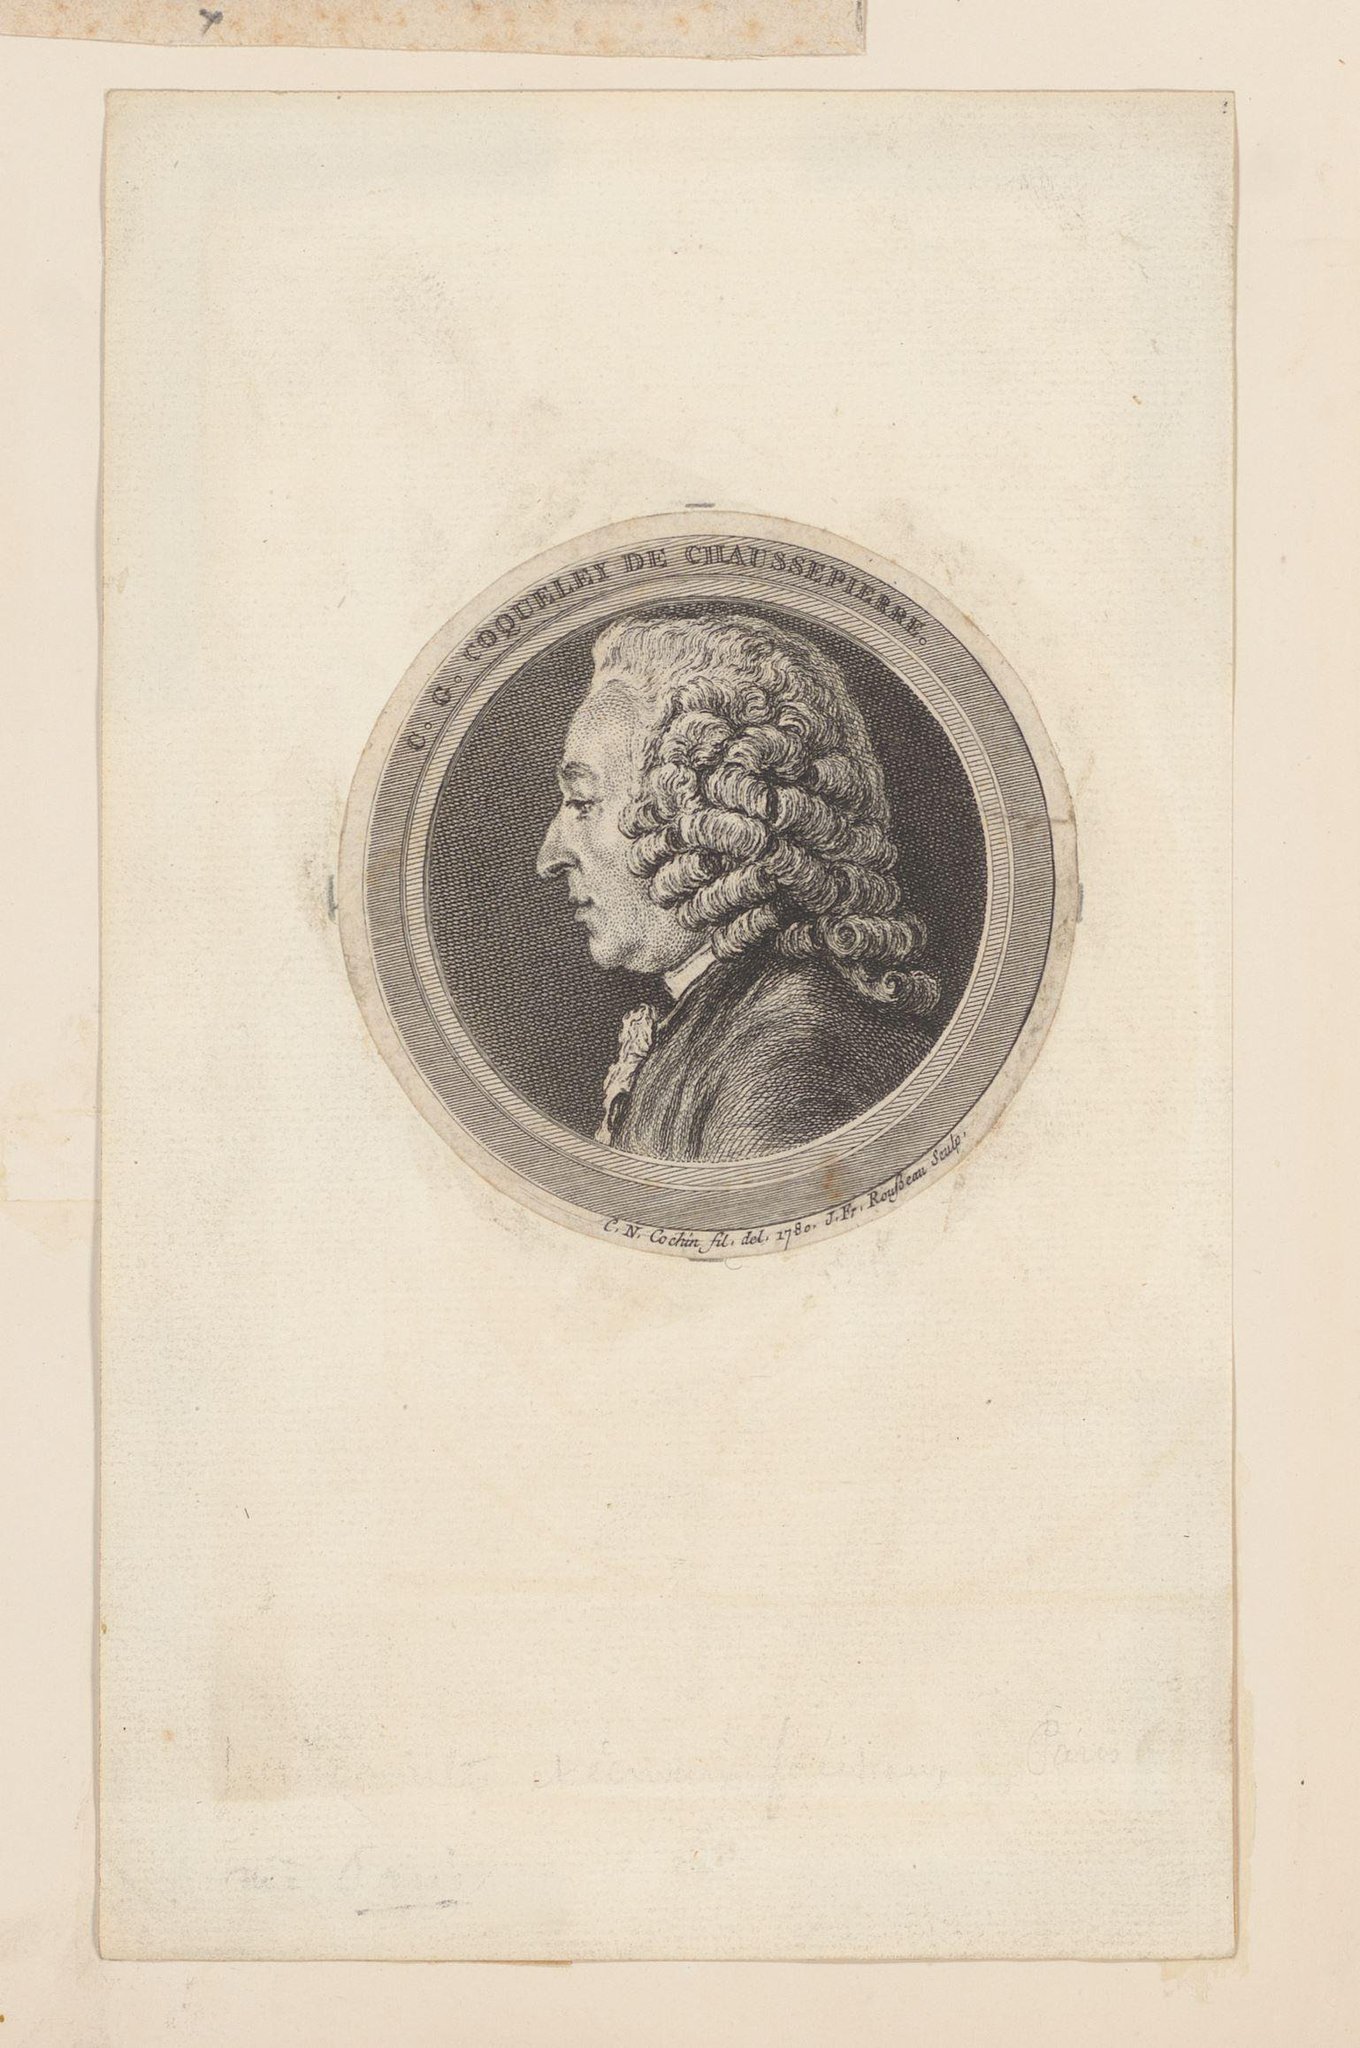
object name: album leaf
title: C.G. Coqueley de Chaussepierre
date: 1780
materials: paper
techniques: engraving, etching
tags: historical persons, administration of justice, trial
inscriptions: date